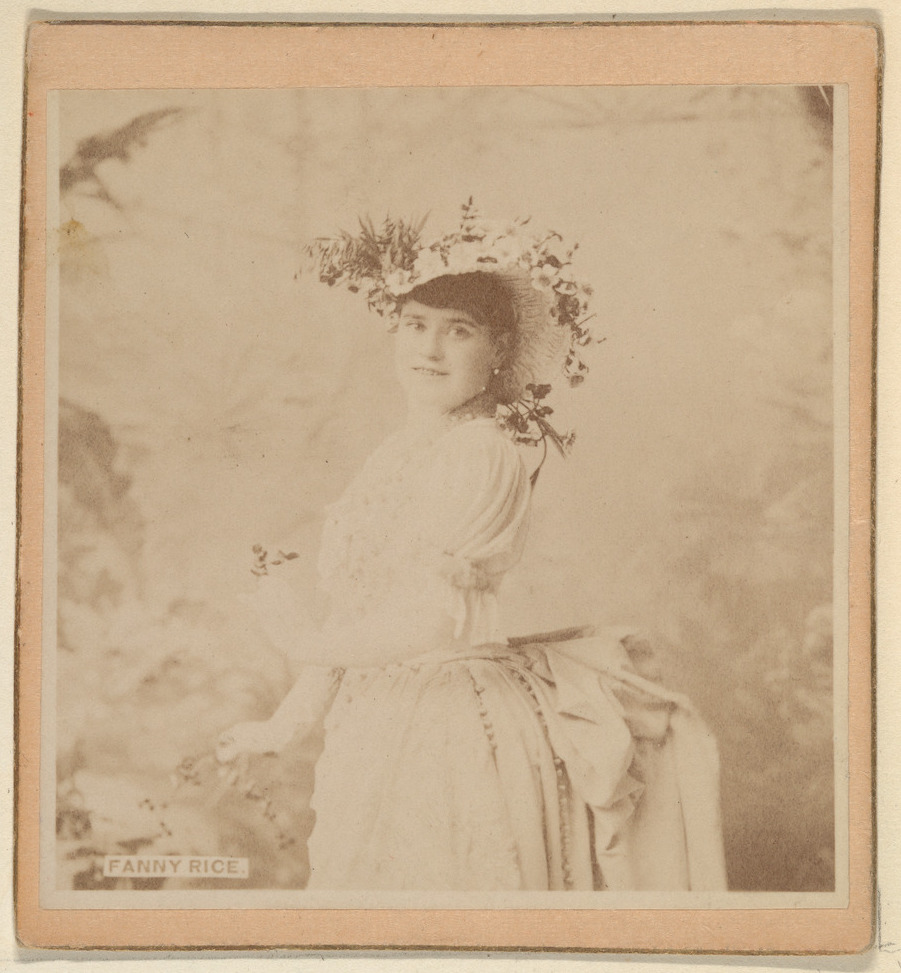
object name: photograph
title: Fanny Rice, from the Actresses series (N246), Type 2, issued by Kinney Brothers to promote Sporting Extra Cigarettes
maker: kinney brothers tobacco company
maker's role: publisher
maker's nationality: american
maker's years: 1869-2011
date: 1890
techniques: albumen silver print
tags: portraits,women,actresses